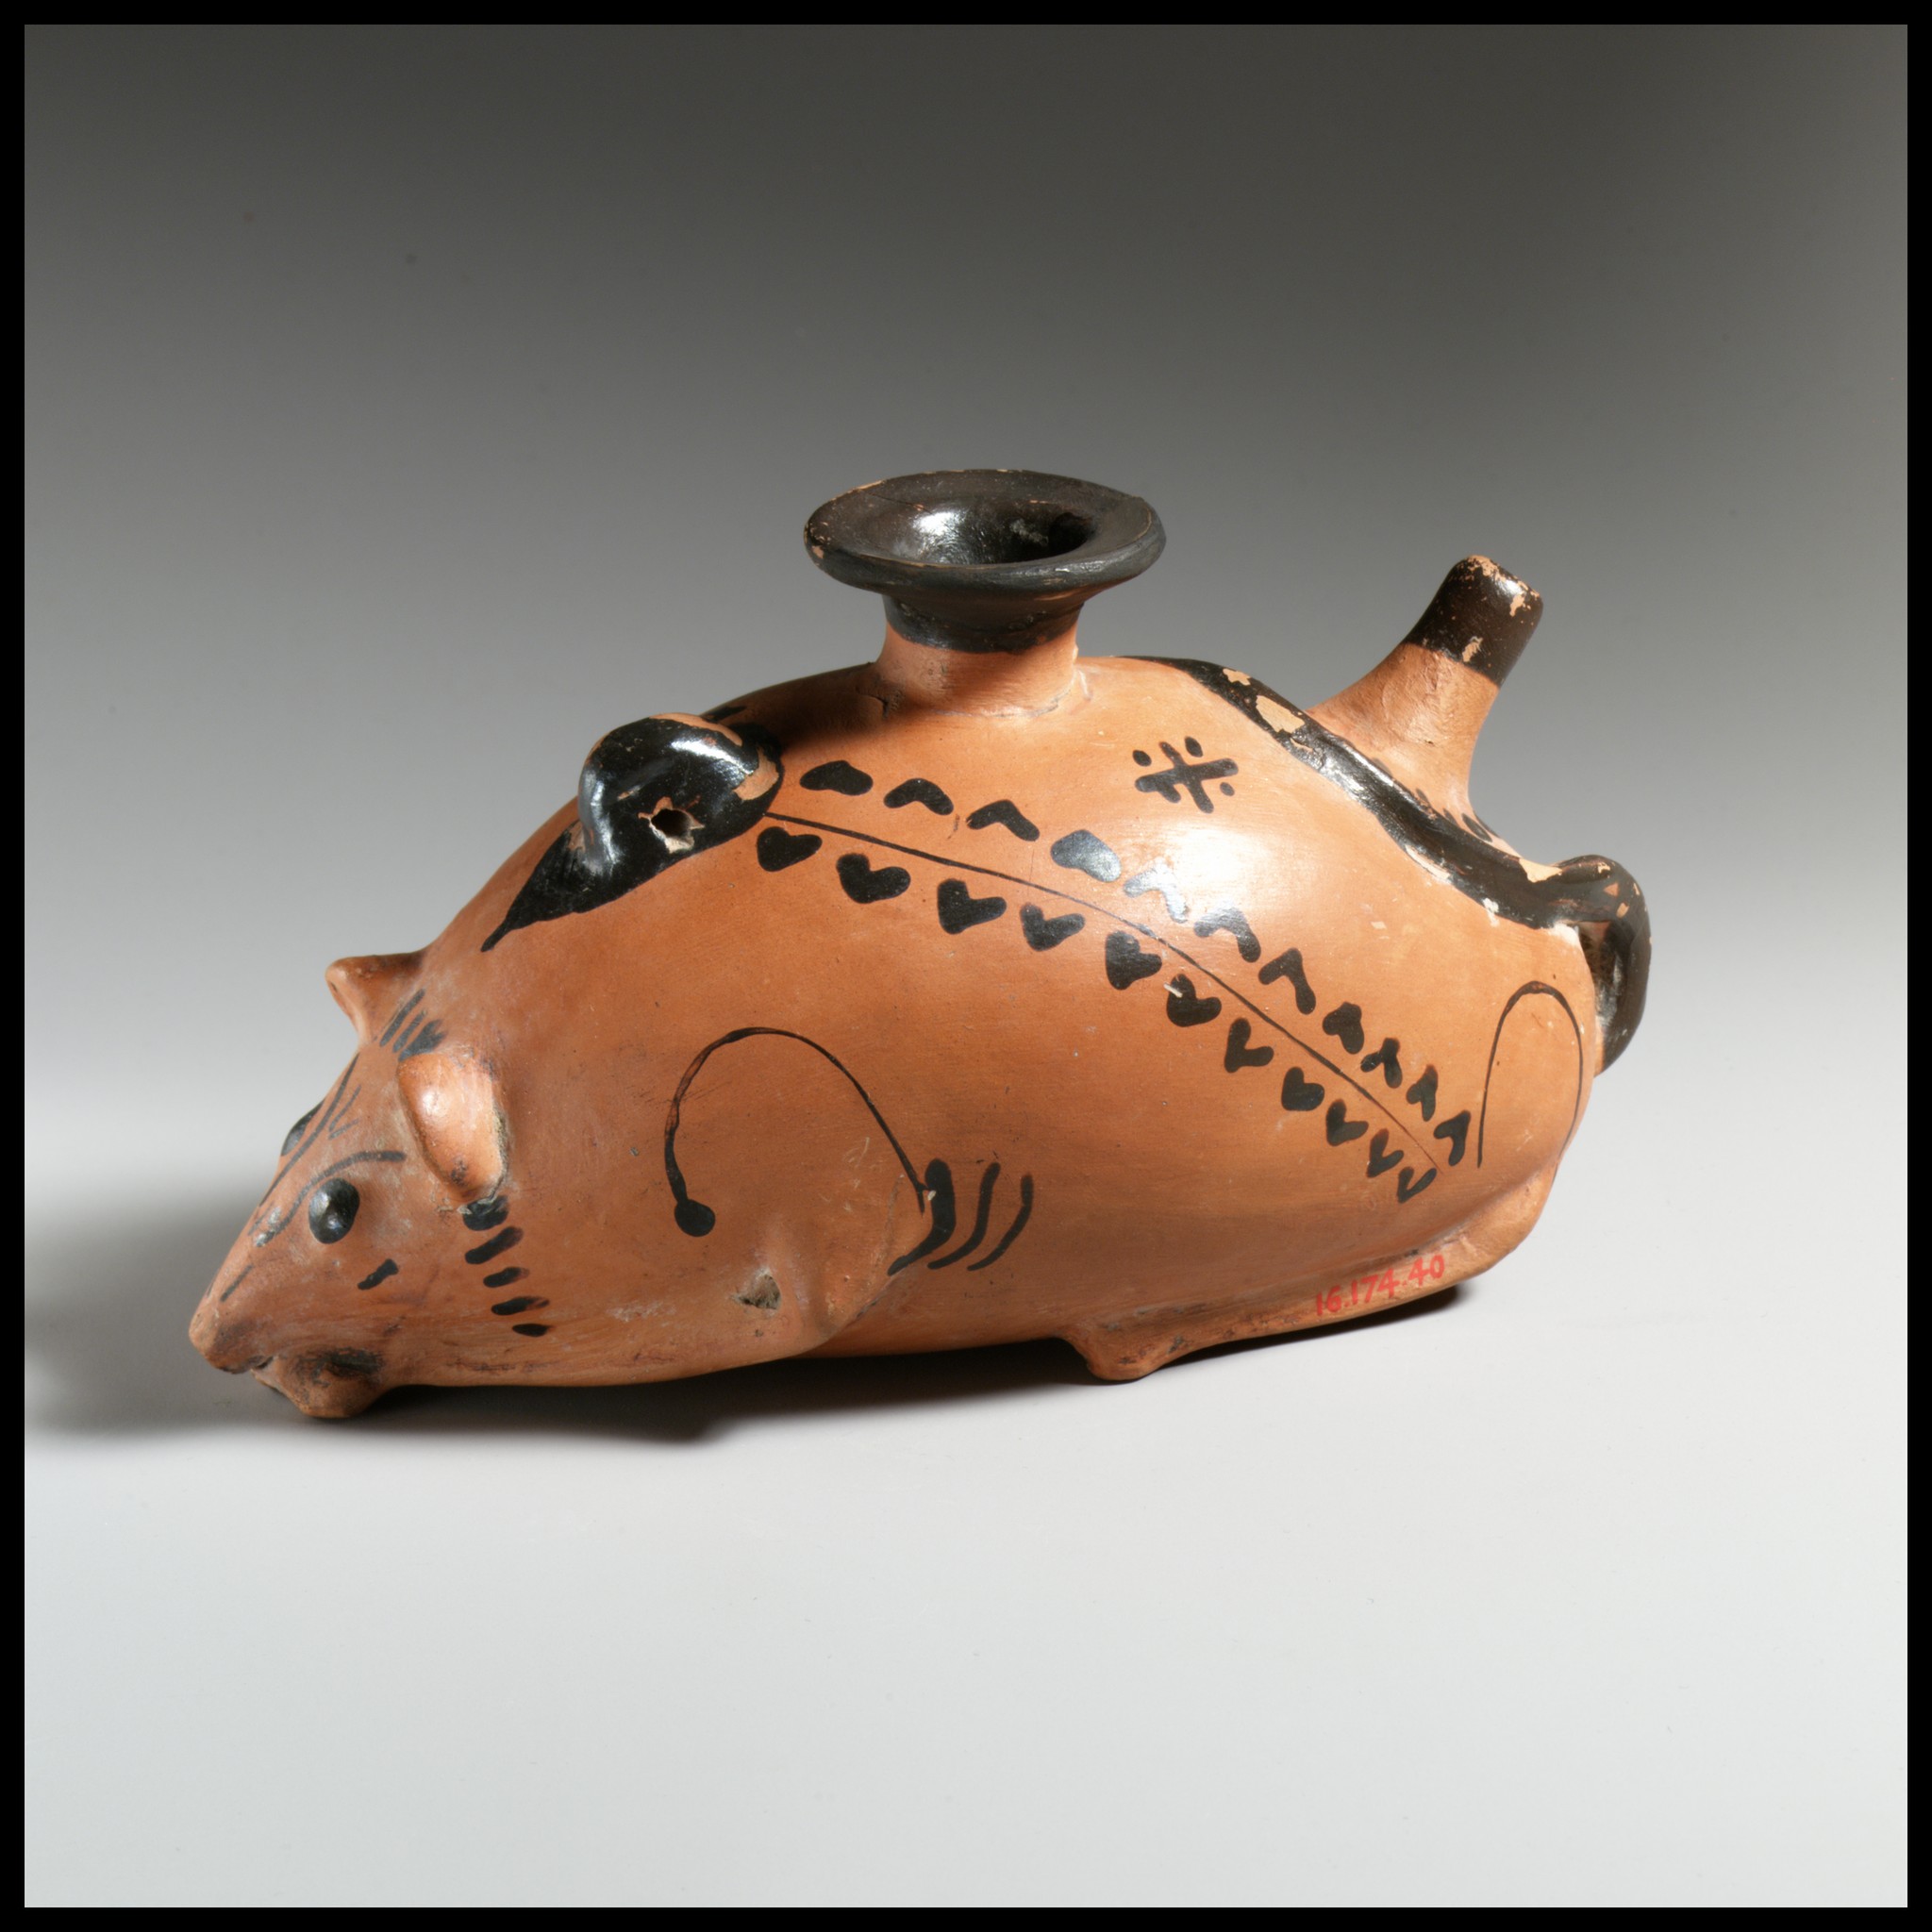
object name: baby feeder in the form of a mouse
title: Terracotta vase in the form of a mouse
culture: greek, sicilian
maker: randazzo group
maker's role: artist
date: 467-435 BCE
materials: terracotta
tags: mice